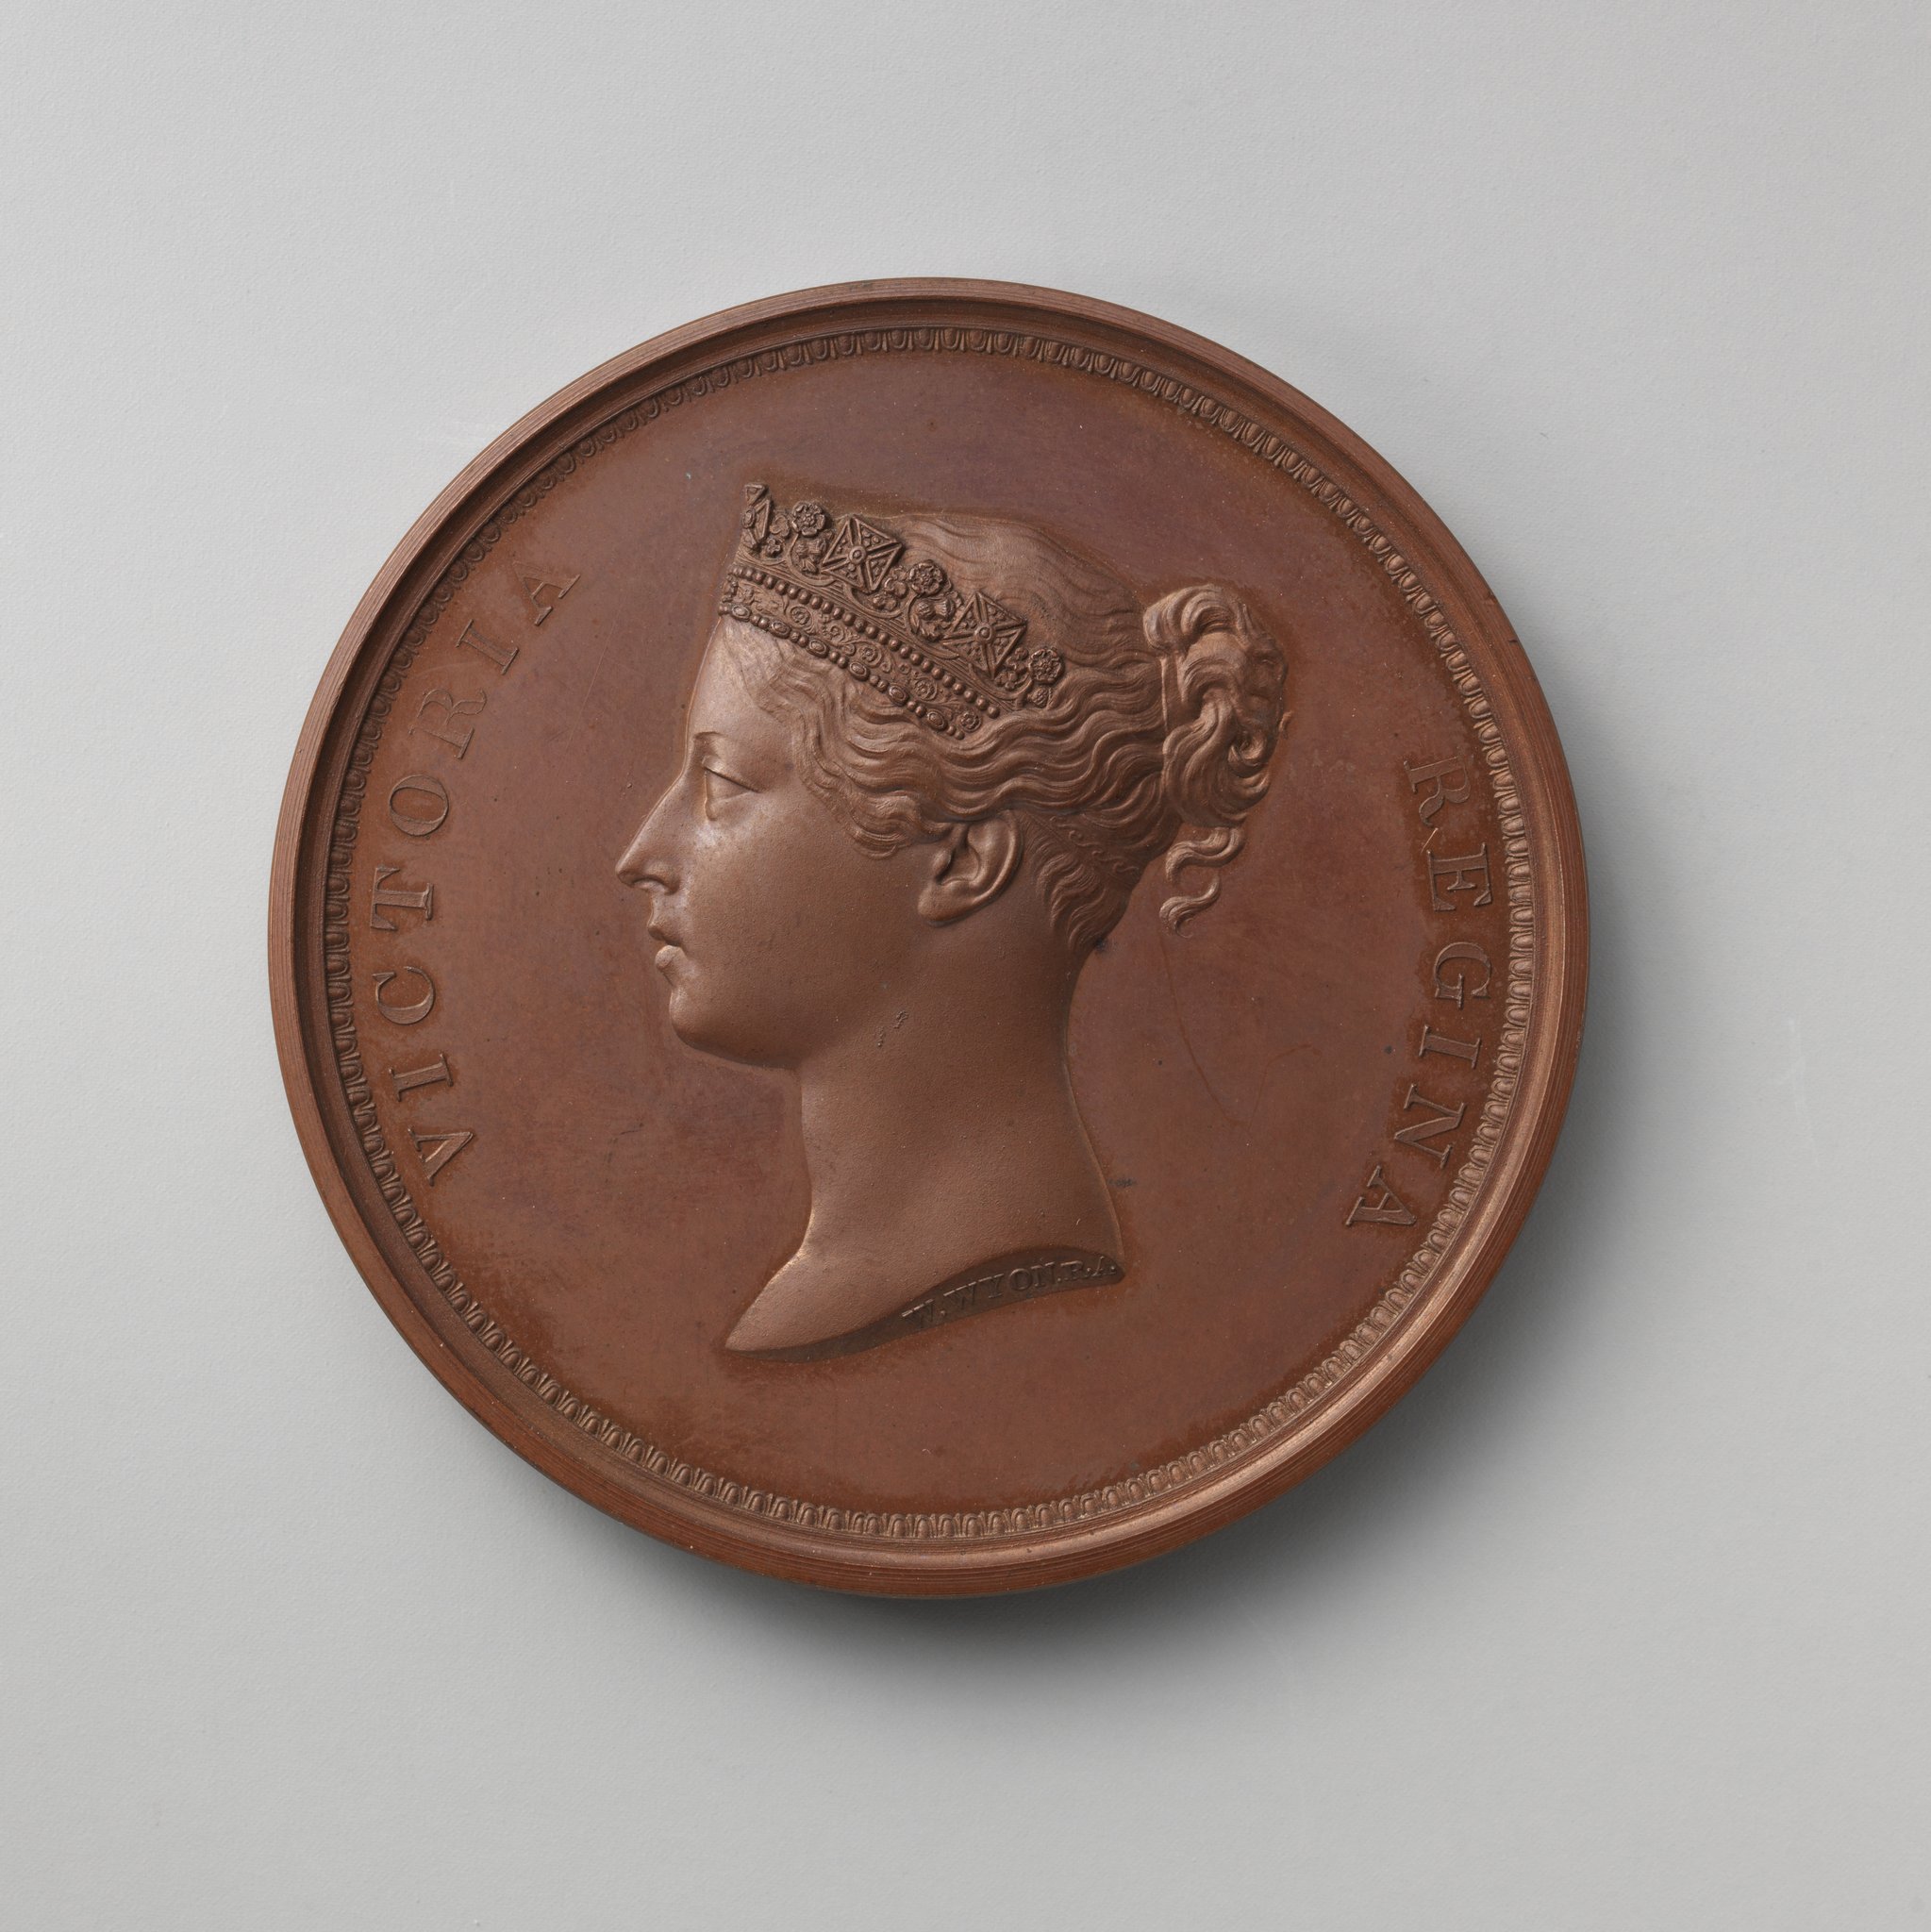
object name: medal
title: Queen's visit to the city in 1837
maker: william wyon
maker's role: artist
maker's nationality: british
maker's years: 1795-1851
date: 1801-1900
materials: bronze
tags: profiles,women